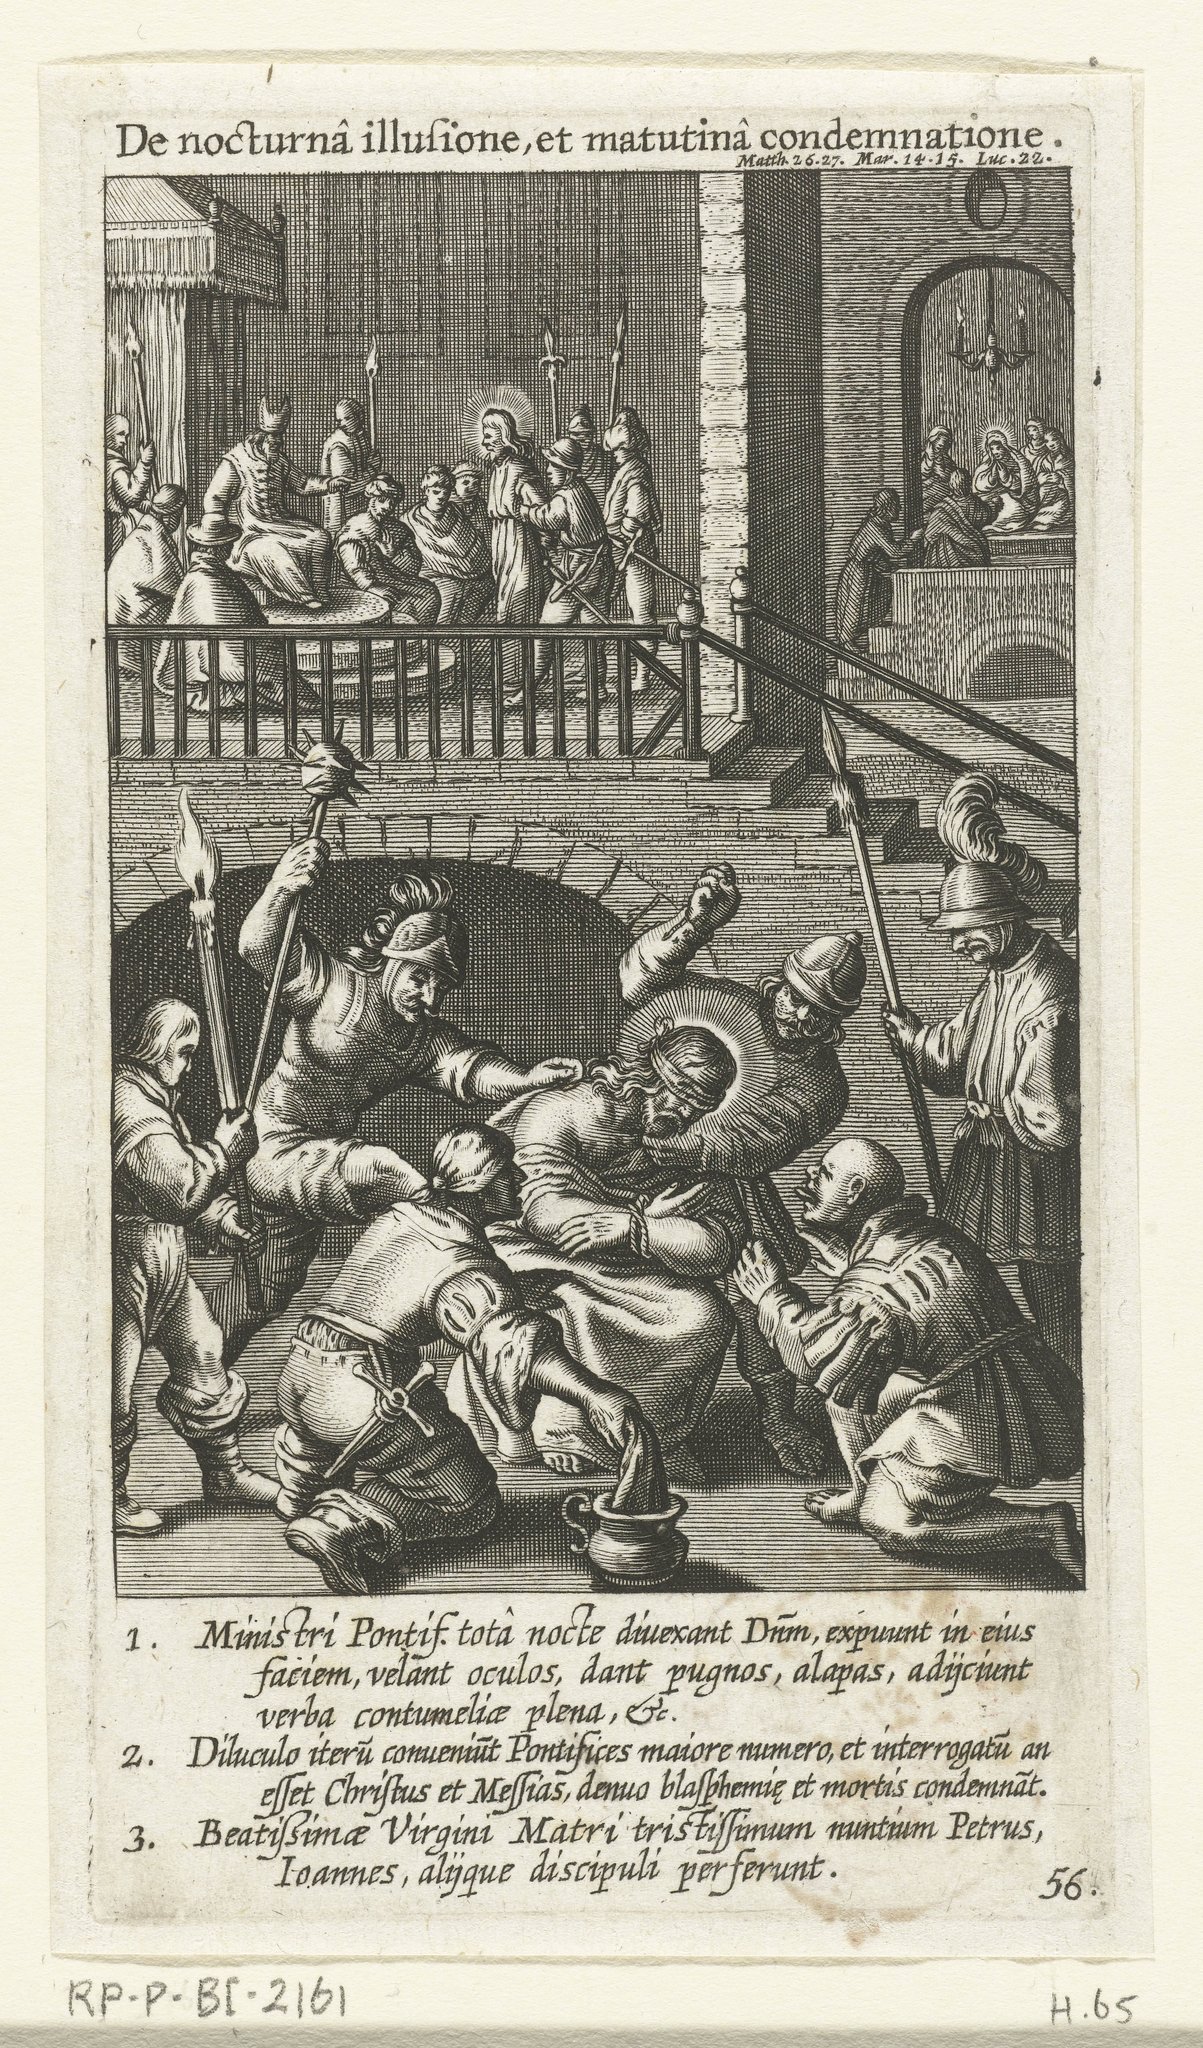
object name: book illustration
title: De nocturna illusione et matutina condemnatione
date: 1590-1622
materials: paper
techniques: engraving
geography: antwerp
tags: christ before the sanhedrin with caiaphas as high priest, and possibly annas; maybe a soldier about to strike christ because he keeps silent (matthew 26:57-66; mark 14:53-64; luke 22:54, 22:66-71), mockings of christ, who may be blindfolded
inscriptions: collector's mark: Lugt 240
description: Prent uit: Joannes Bourgois, Vitae passionis et mortis Jesu Christi Somini nostri mysteria, Antwerpen Hendrick Aertssens, 1622, afb. 56